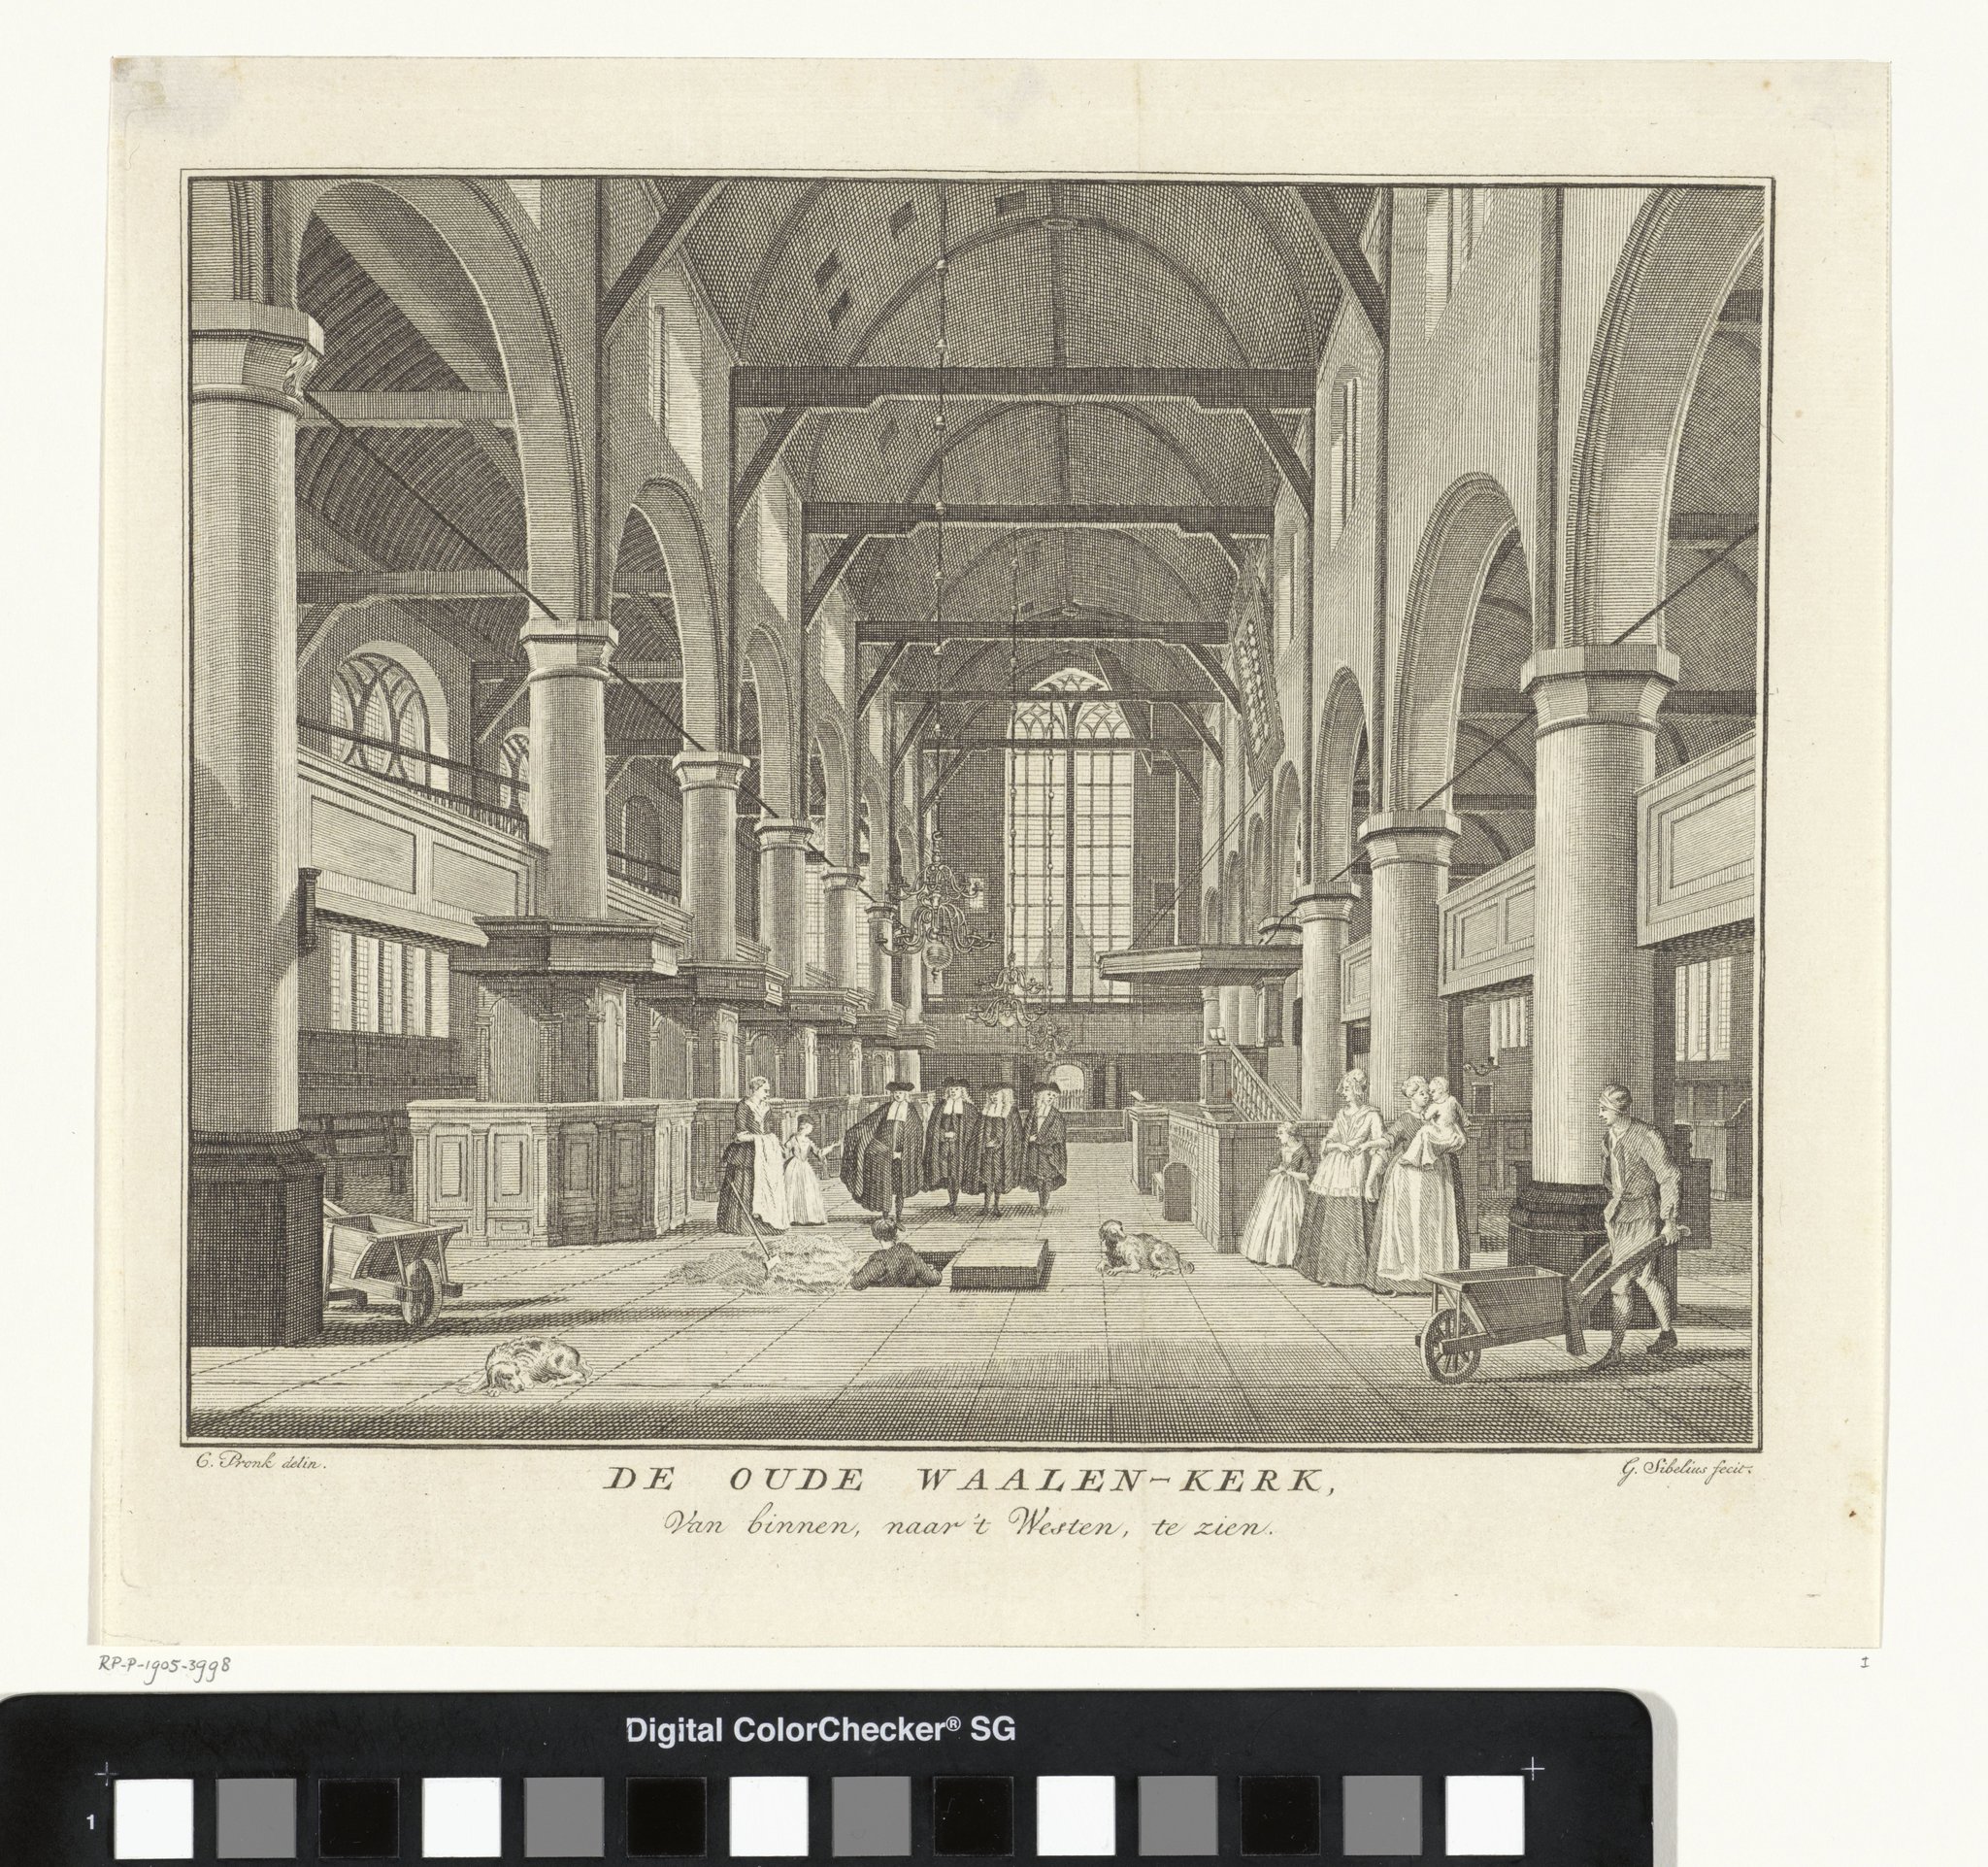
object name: print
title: De Oude Waalen-Kerk van binnen, naar 't Westen, te zien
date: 1760-1765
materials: paper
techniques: engraving, etching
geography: amsterdam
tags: interior of church, wheelbarrow, grave digger, dog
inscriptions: collector's mark: Lugt 2228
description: Interieur van de Oude Waalse kerk aan de Oudezijds Achterburgwal in Amsterdam. Mensen kijken toe hoe een graf gedolven wordt. Rechts een man met een kruiwagen. Twee honden liggen op de vloer.